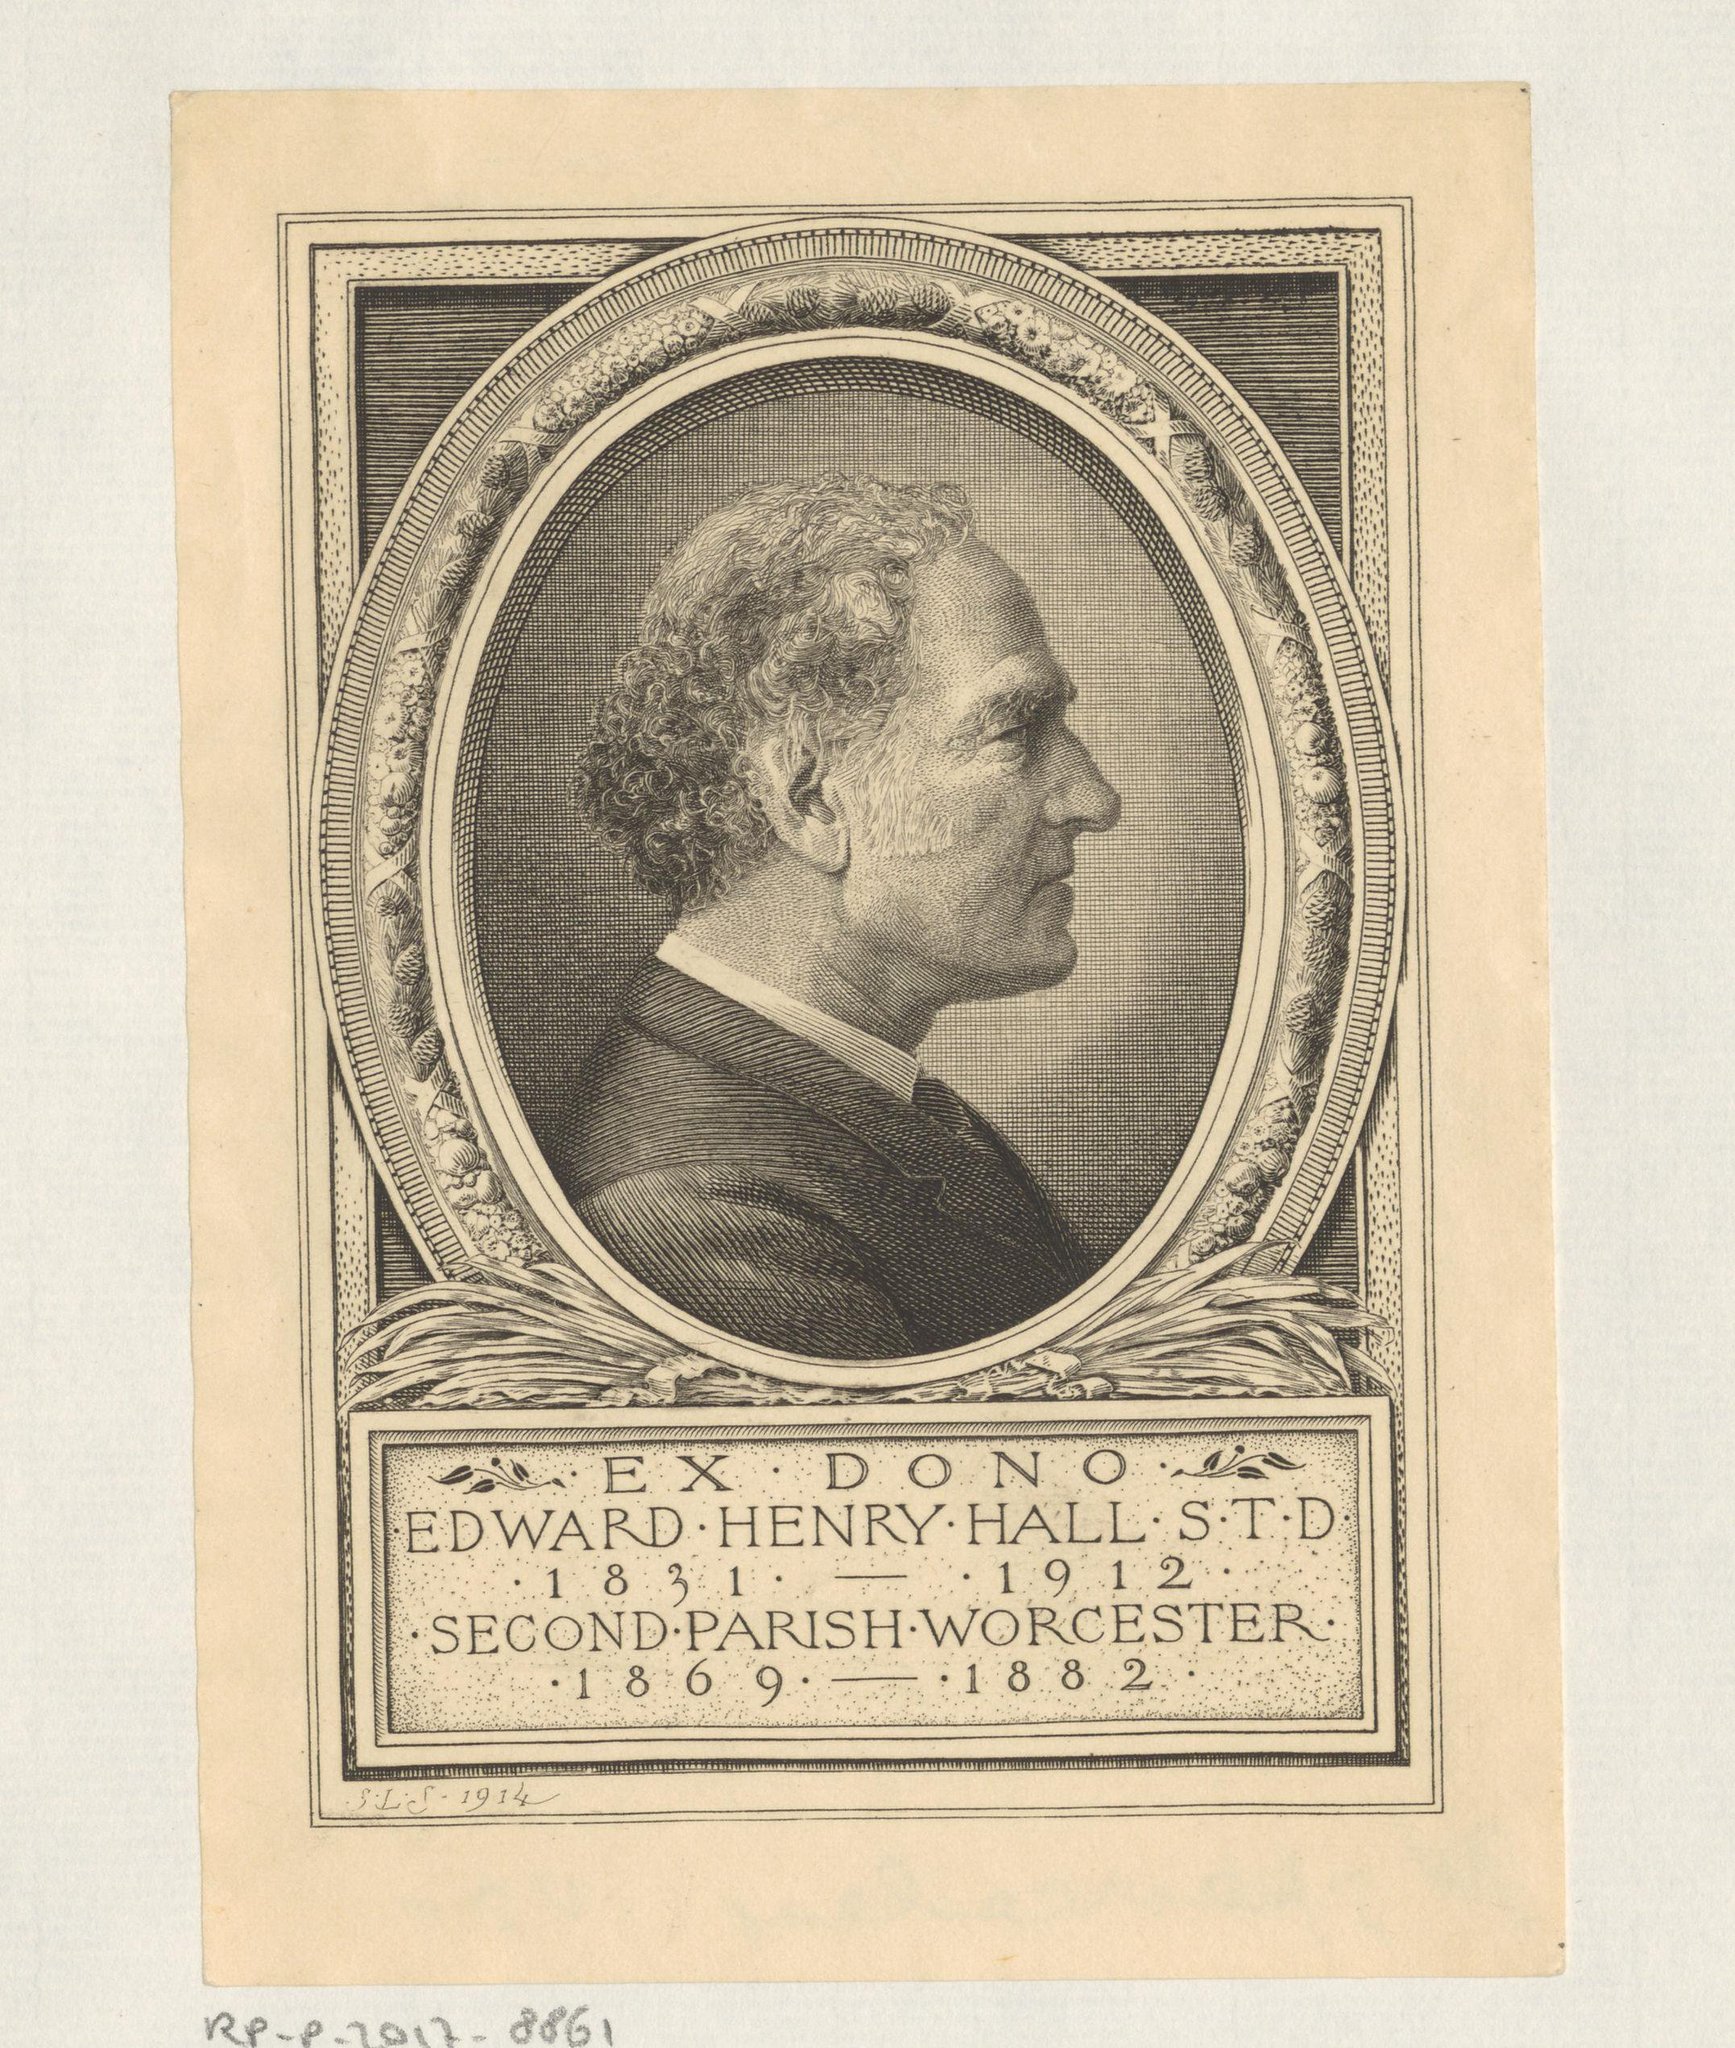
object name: bookplate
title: Ex libris van Edward Henry Hall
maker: sidney lawton smith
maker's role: graveur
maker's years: 1848-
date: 1914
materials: paper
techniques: engraving, etching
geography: north and central america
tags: historical persons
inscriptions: date